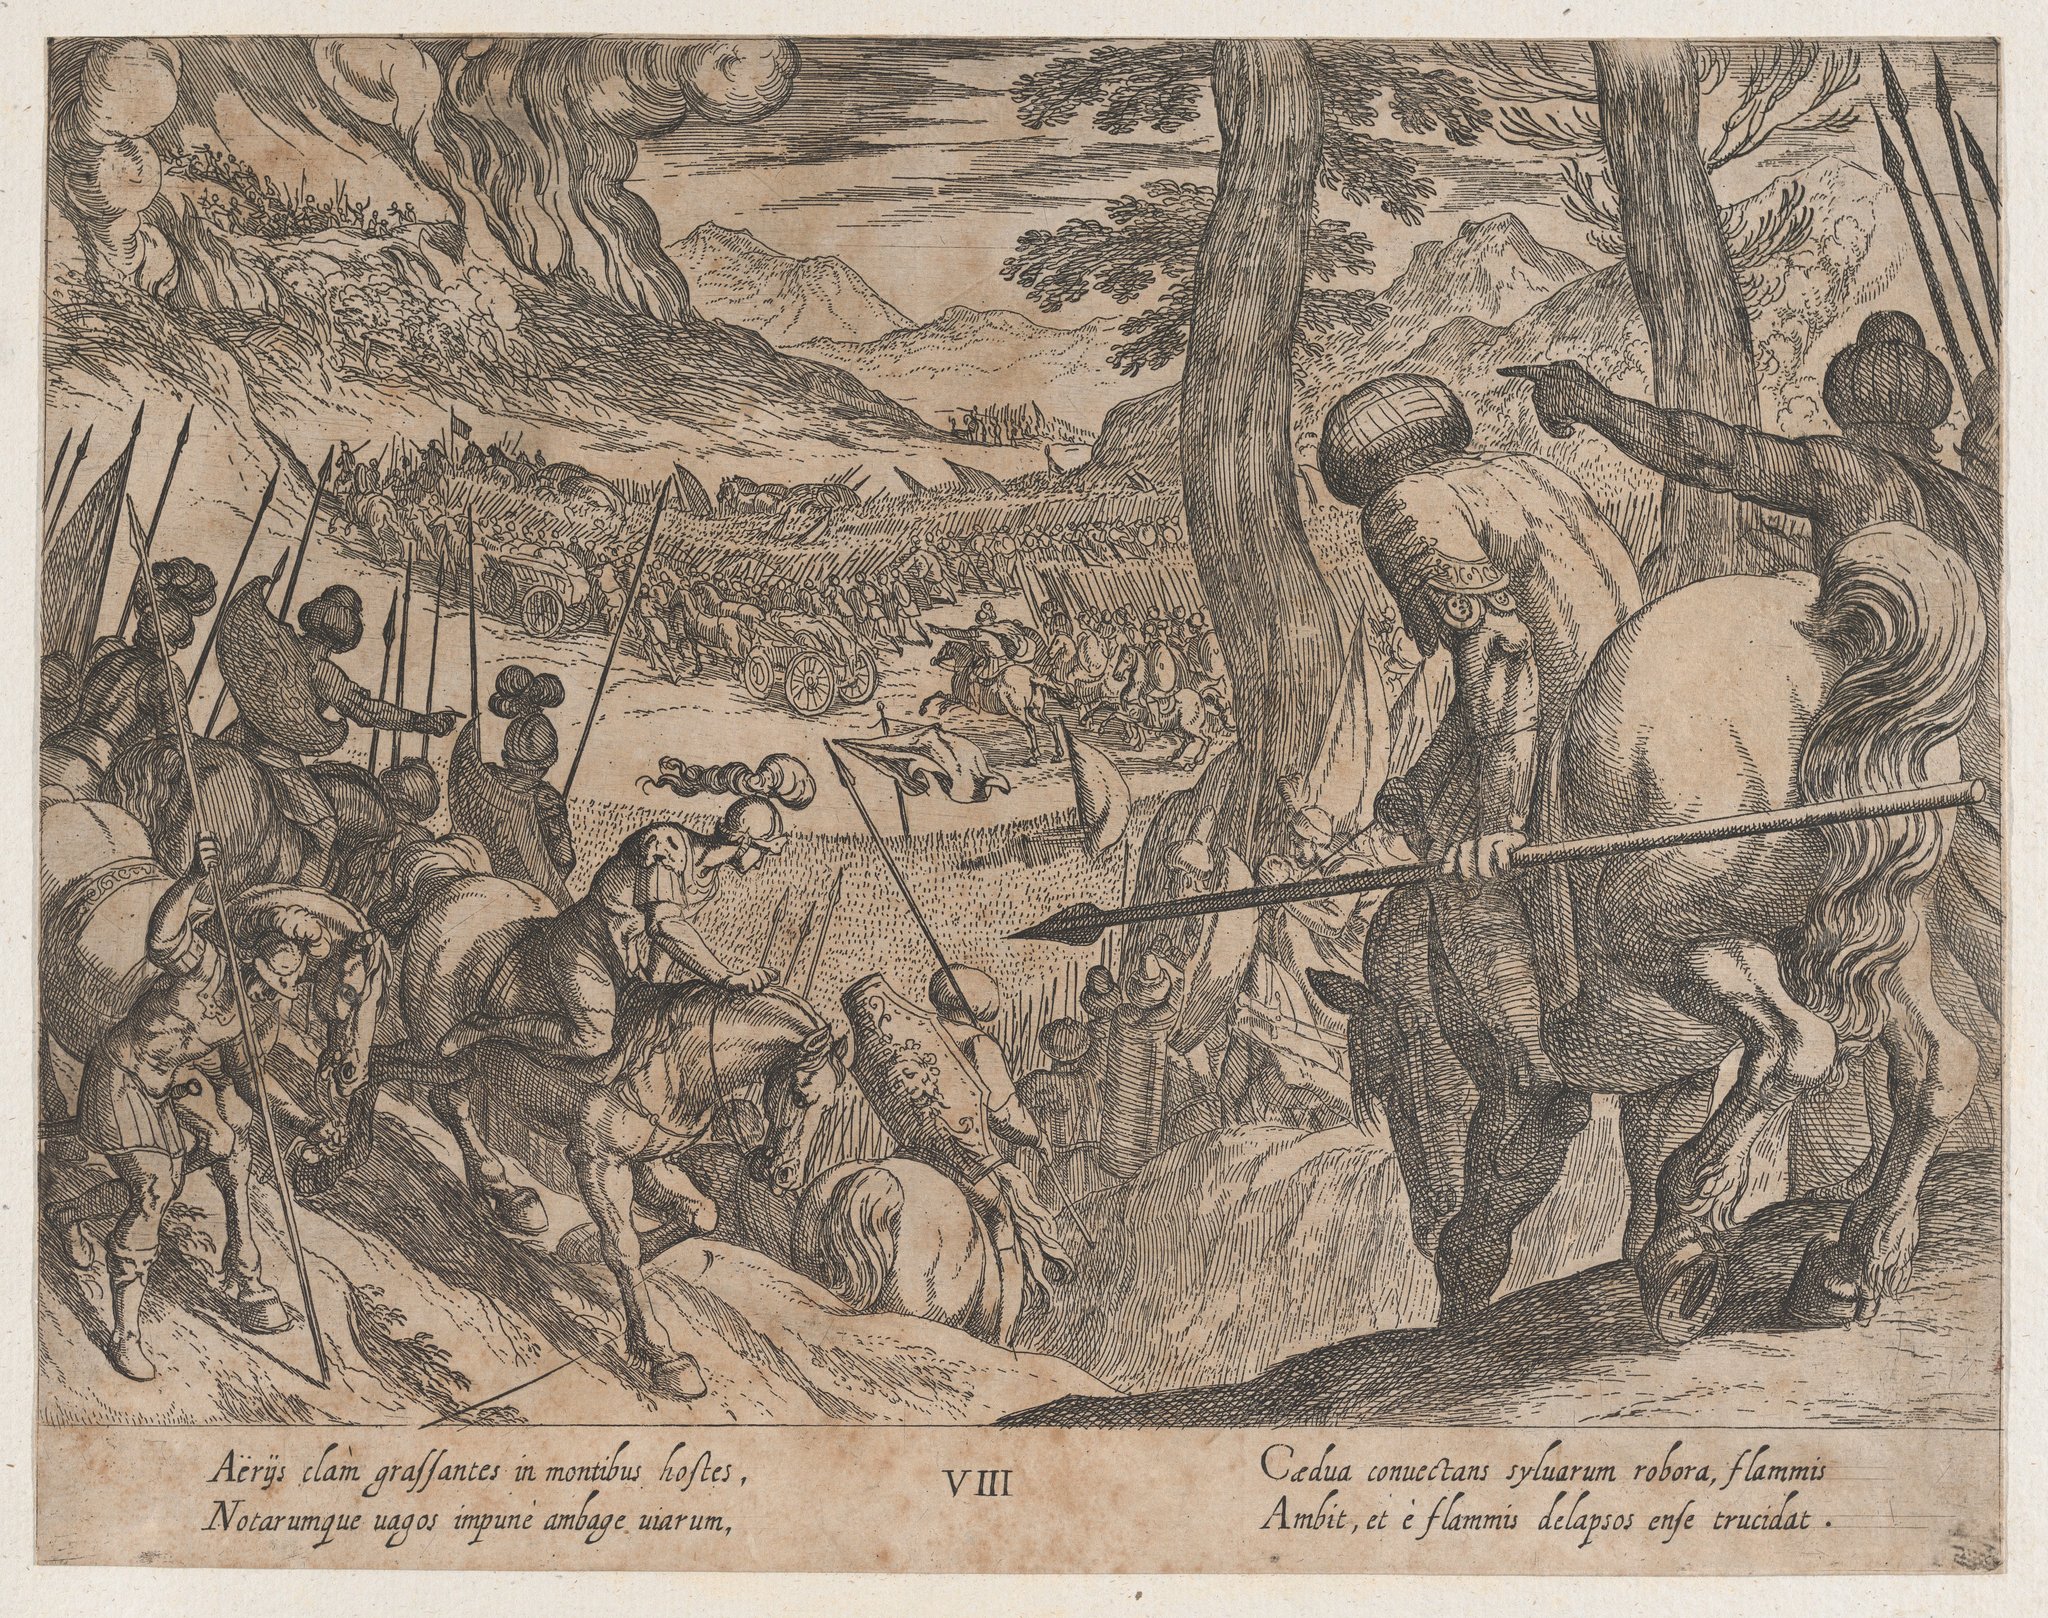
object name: print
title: Plate 8: Alexander Encircling the Enemy Troops with Fire, from "The Deeds of Alexander the Great"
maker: antonio tempesta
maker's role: artist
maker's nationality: italian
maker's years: 1555-1630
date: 1608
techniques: etching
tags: wars,weapons,alexander the great,horses